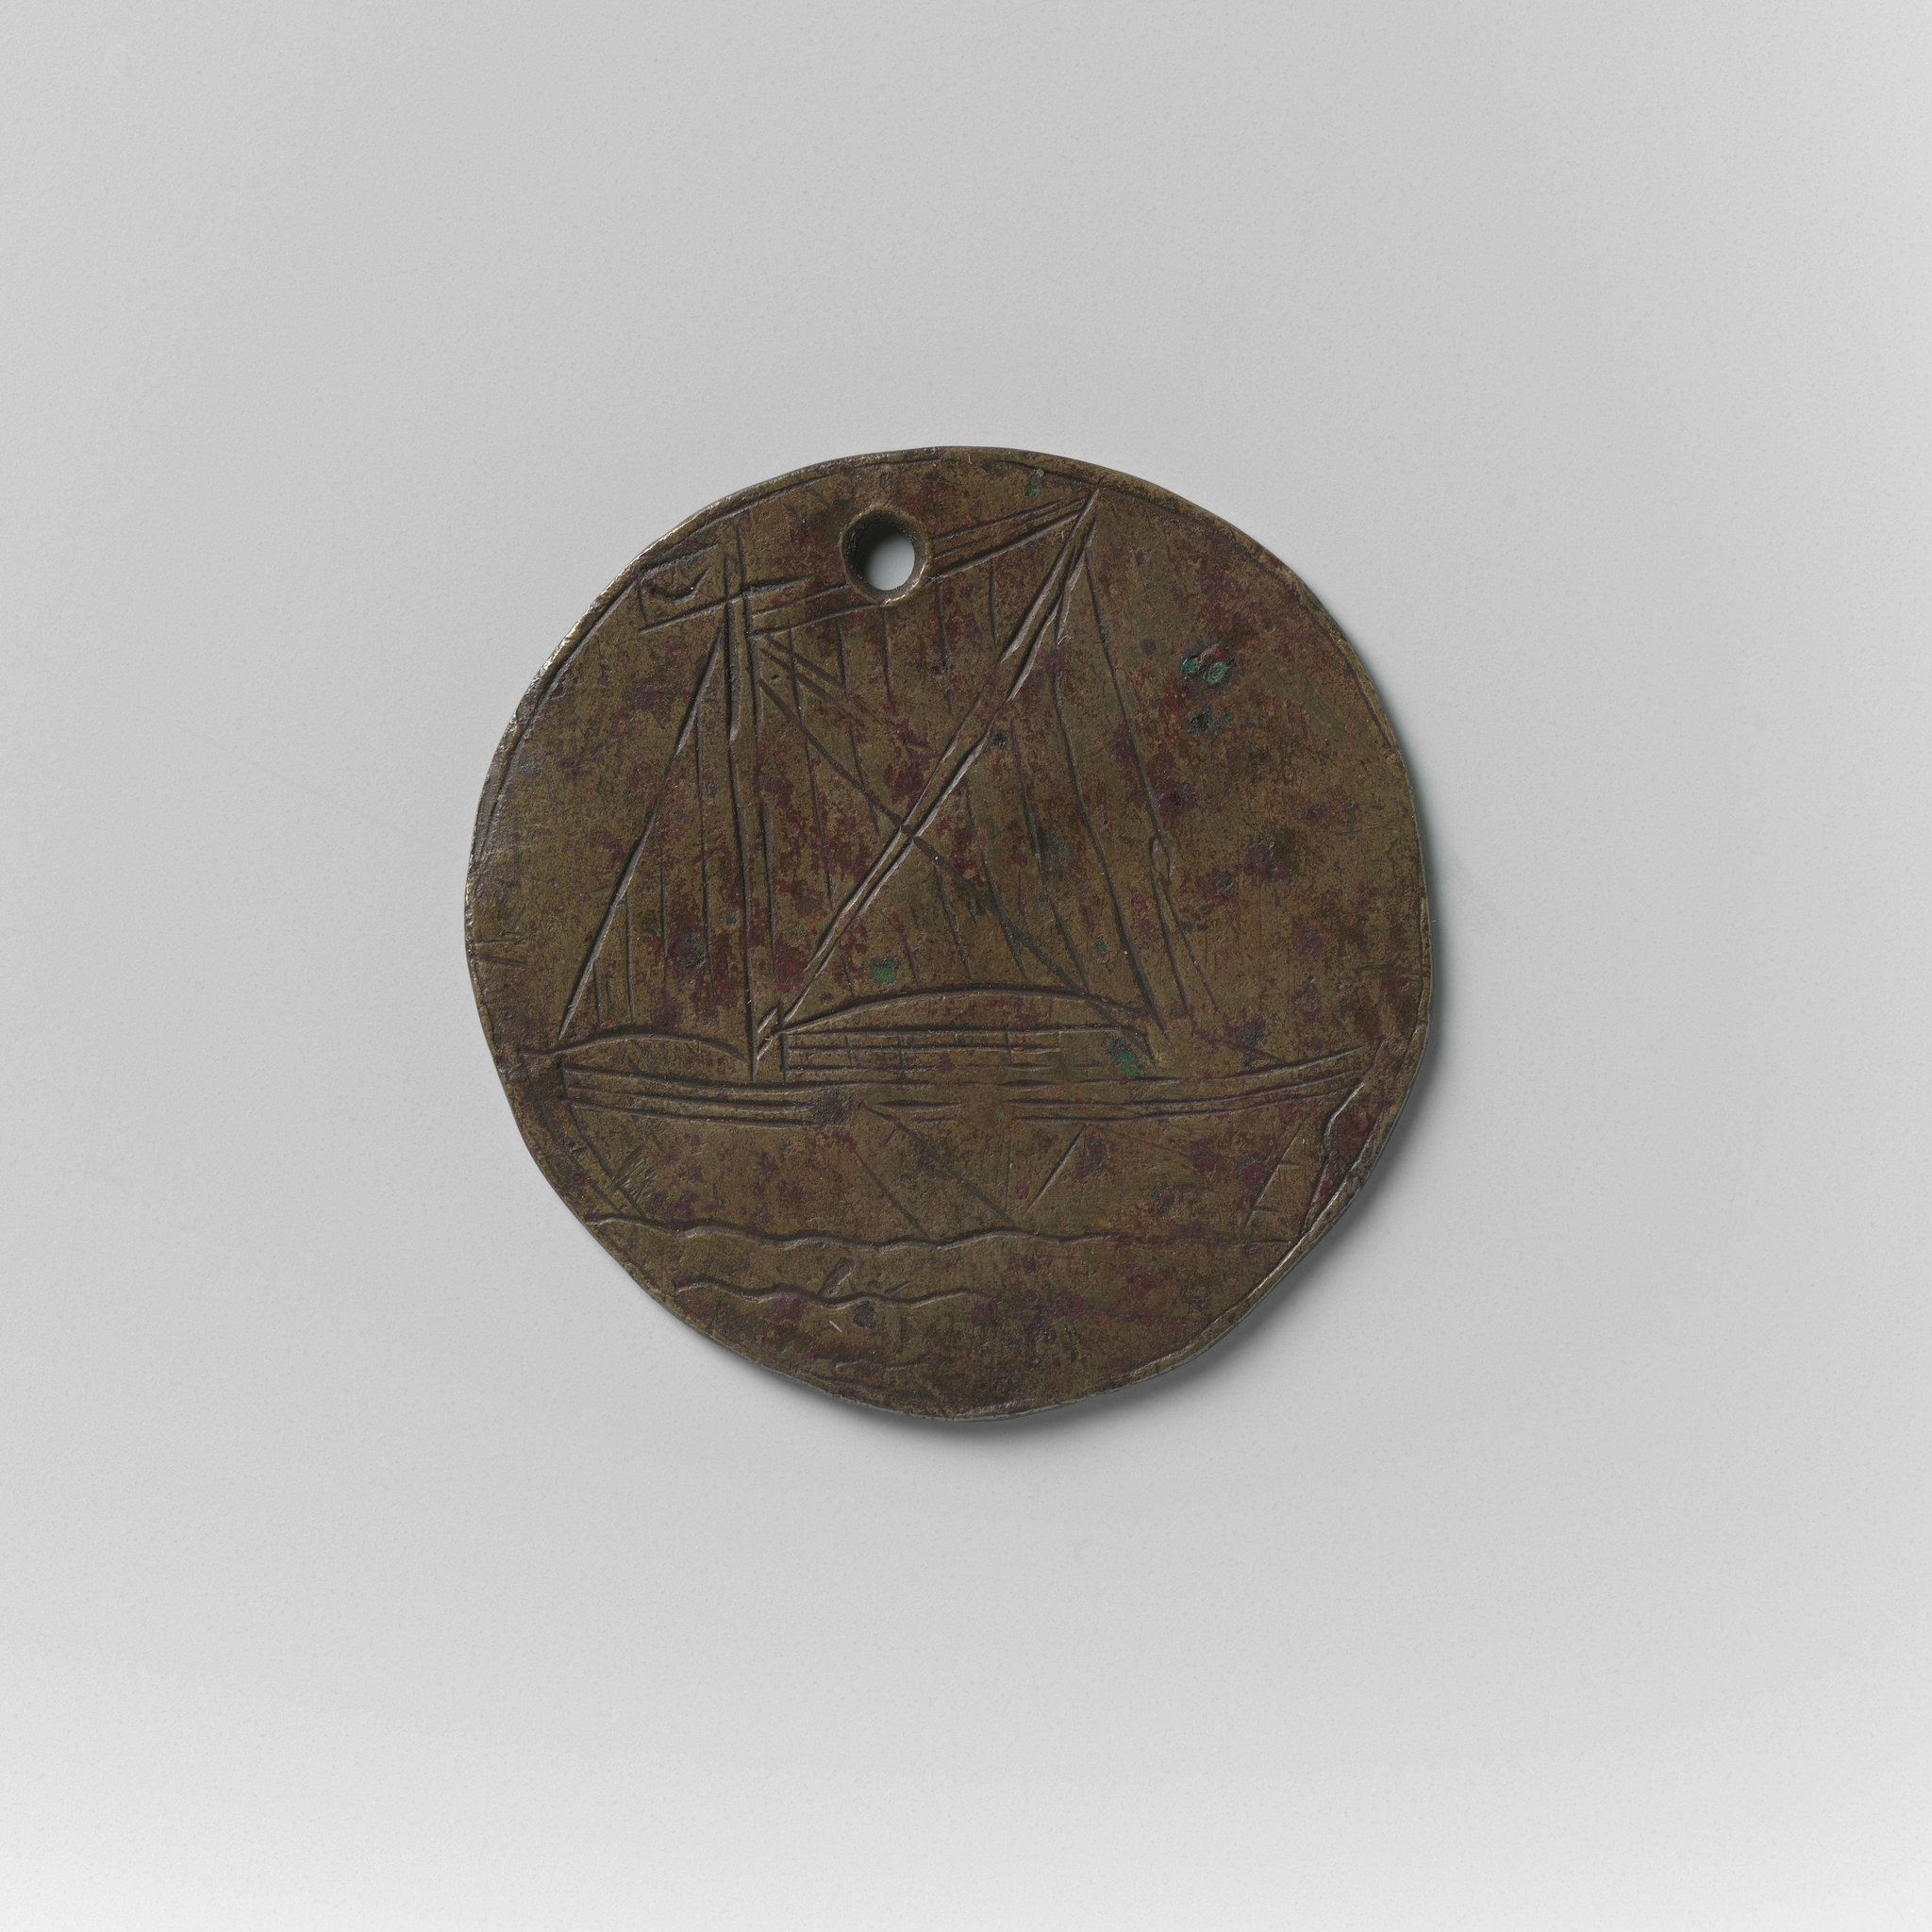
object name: history medal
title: Presentiepenning van het Klein Binnenlandvaardersgilde te Amsterdam 1650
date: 1650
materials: brass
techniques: engraving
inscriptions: inscription: ‘DIRCK / BVYS’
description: Ronde plaat messing gegraveerd op de voorzijde een zeilschip naar links, op de keerzijde twee regels tekst, op naam van Dirck Buys, met draaggat